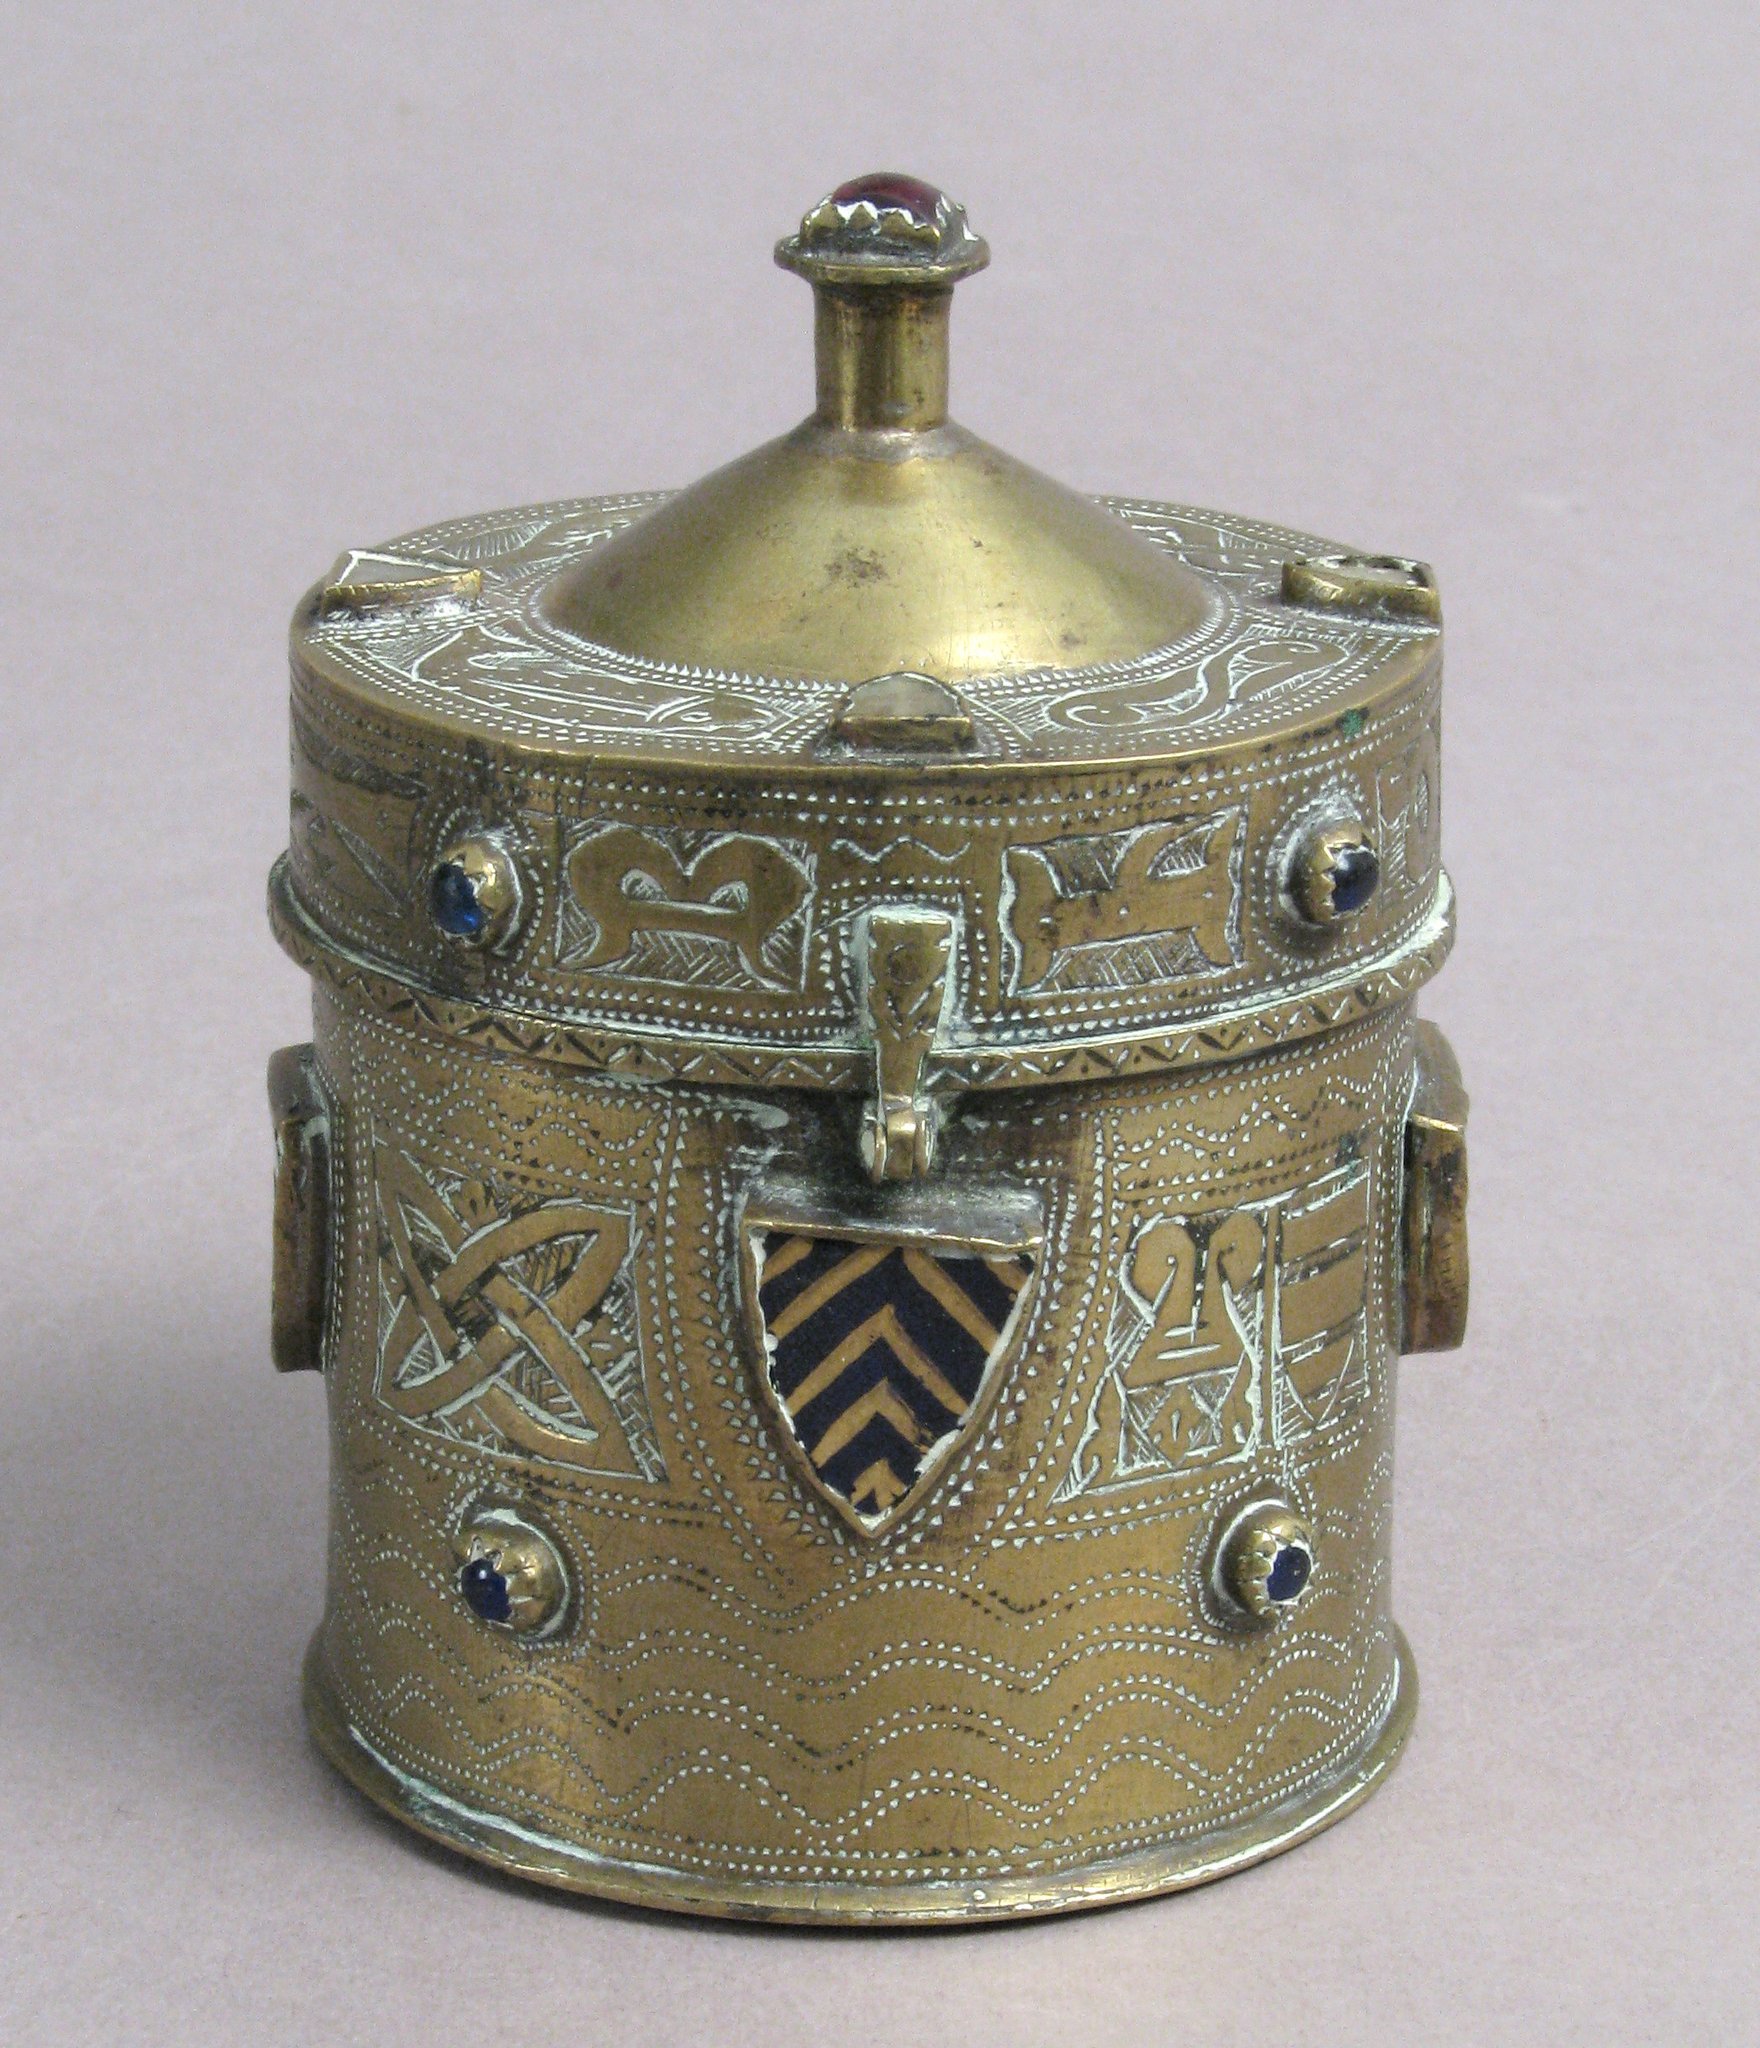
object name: pyx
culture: franco-sicilian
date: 1301-1400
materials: gilt copper, glass, gold